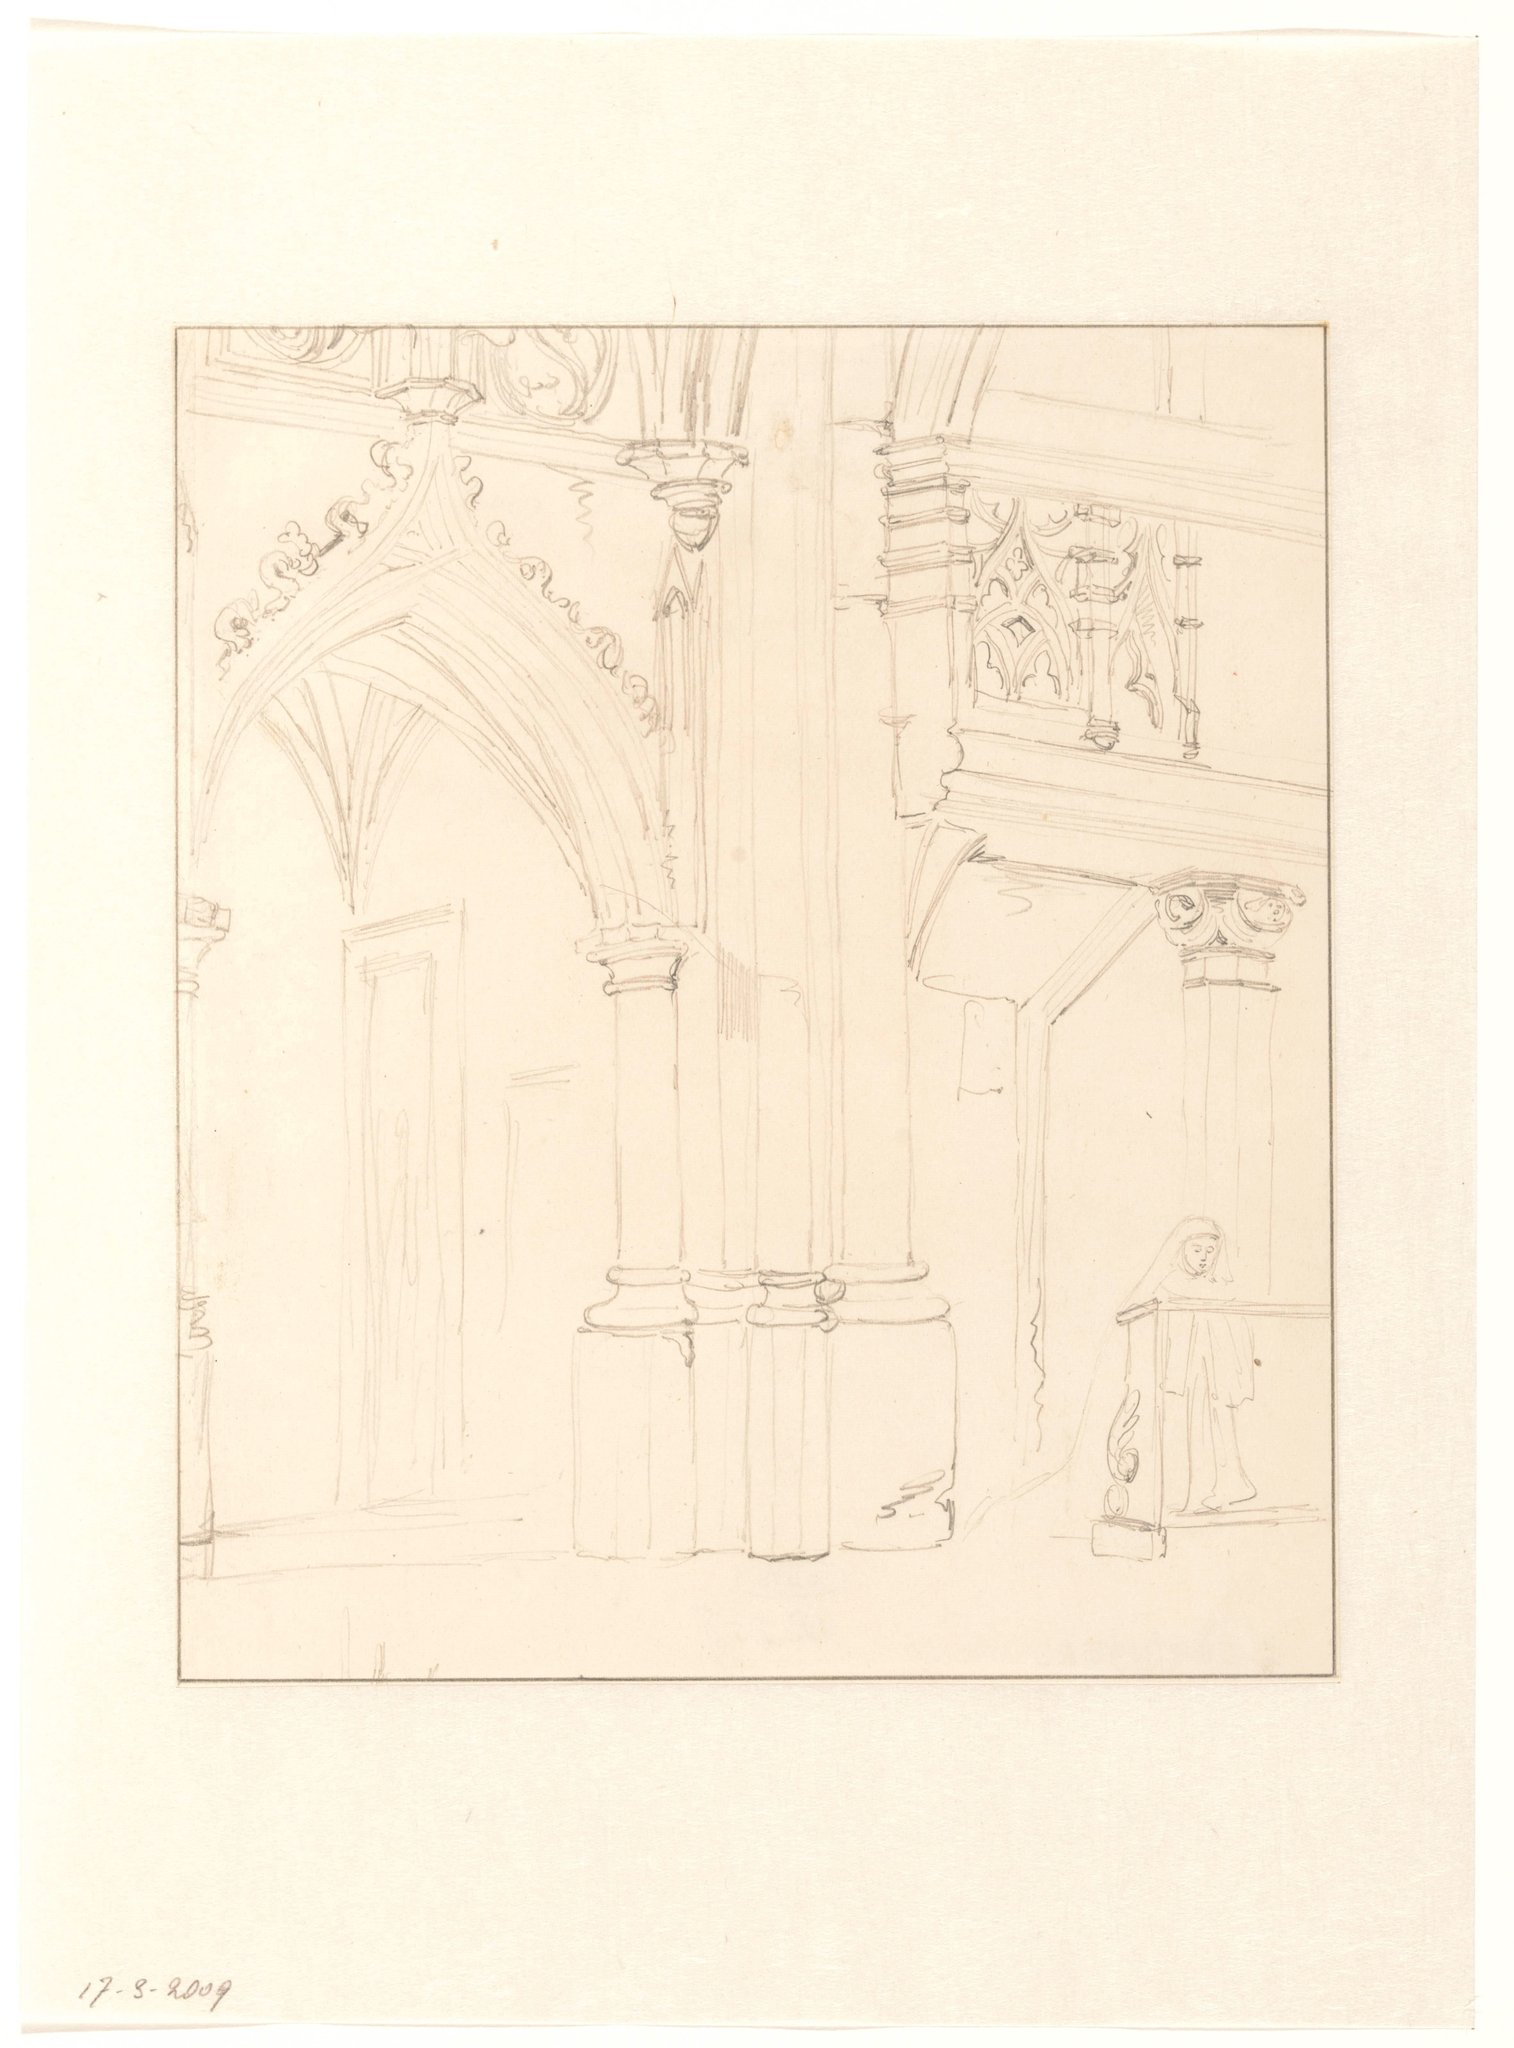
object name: drawing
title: Kerkinterieur met nonnetje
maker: cornelis springer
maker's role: draughtsman, painter, print maker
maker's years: 1817-1891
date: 1827-1891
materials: paper, pencil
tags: nun(s), interior of church